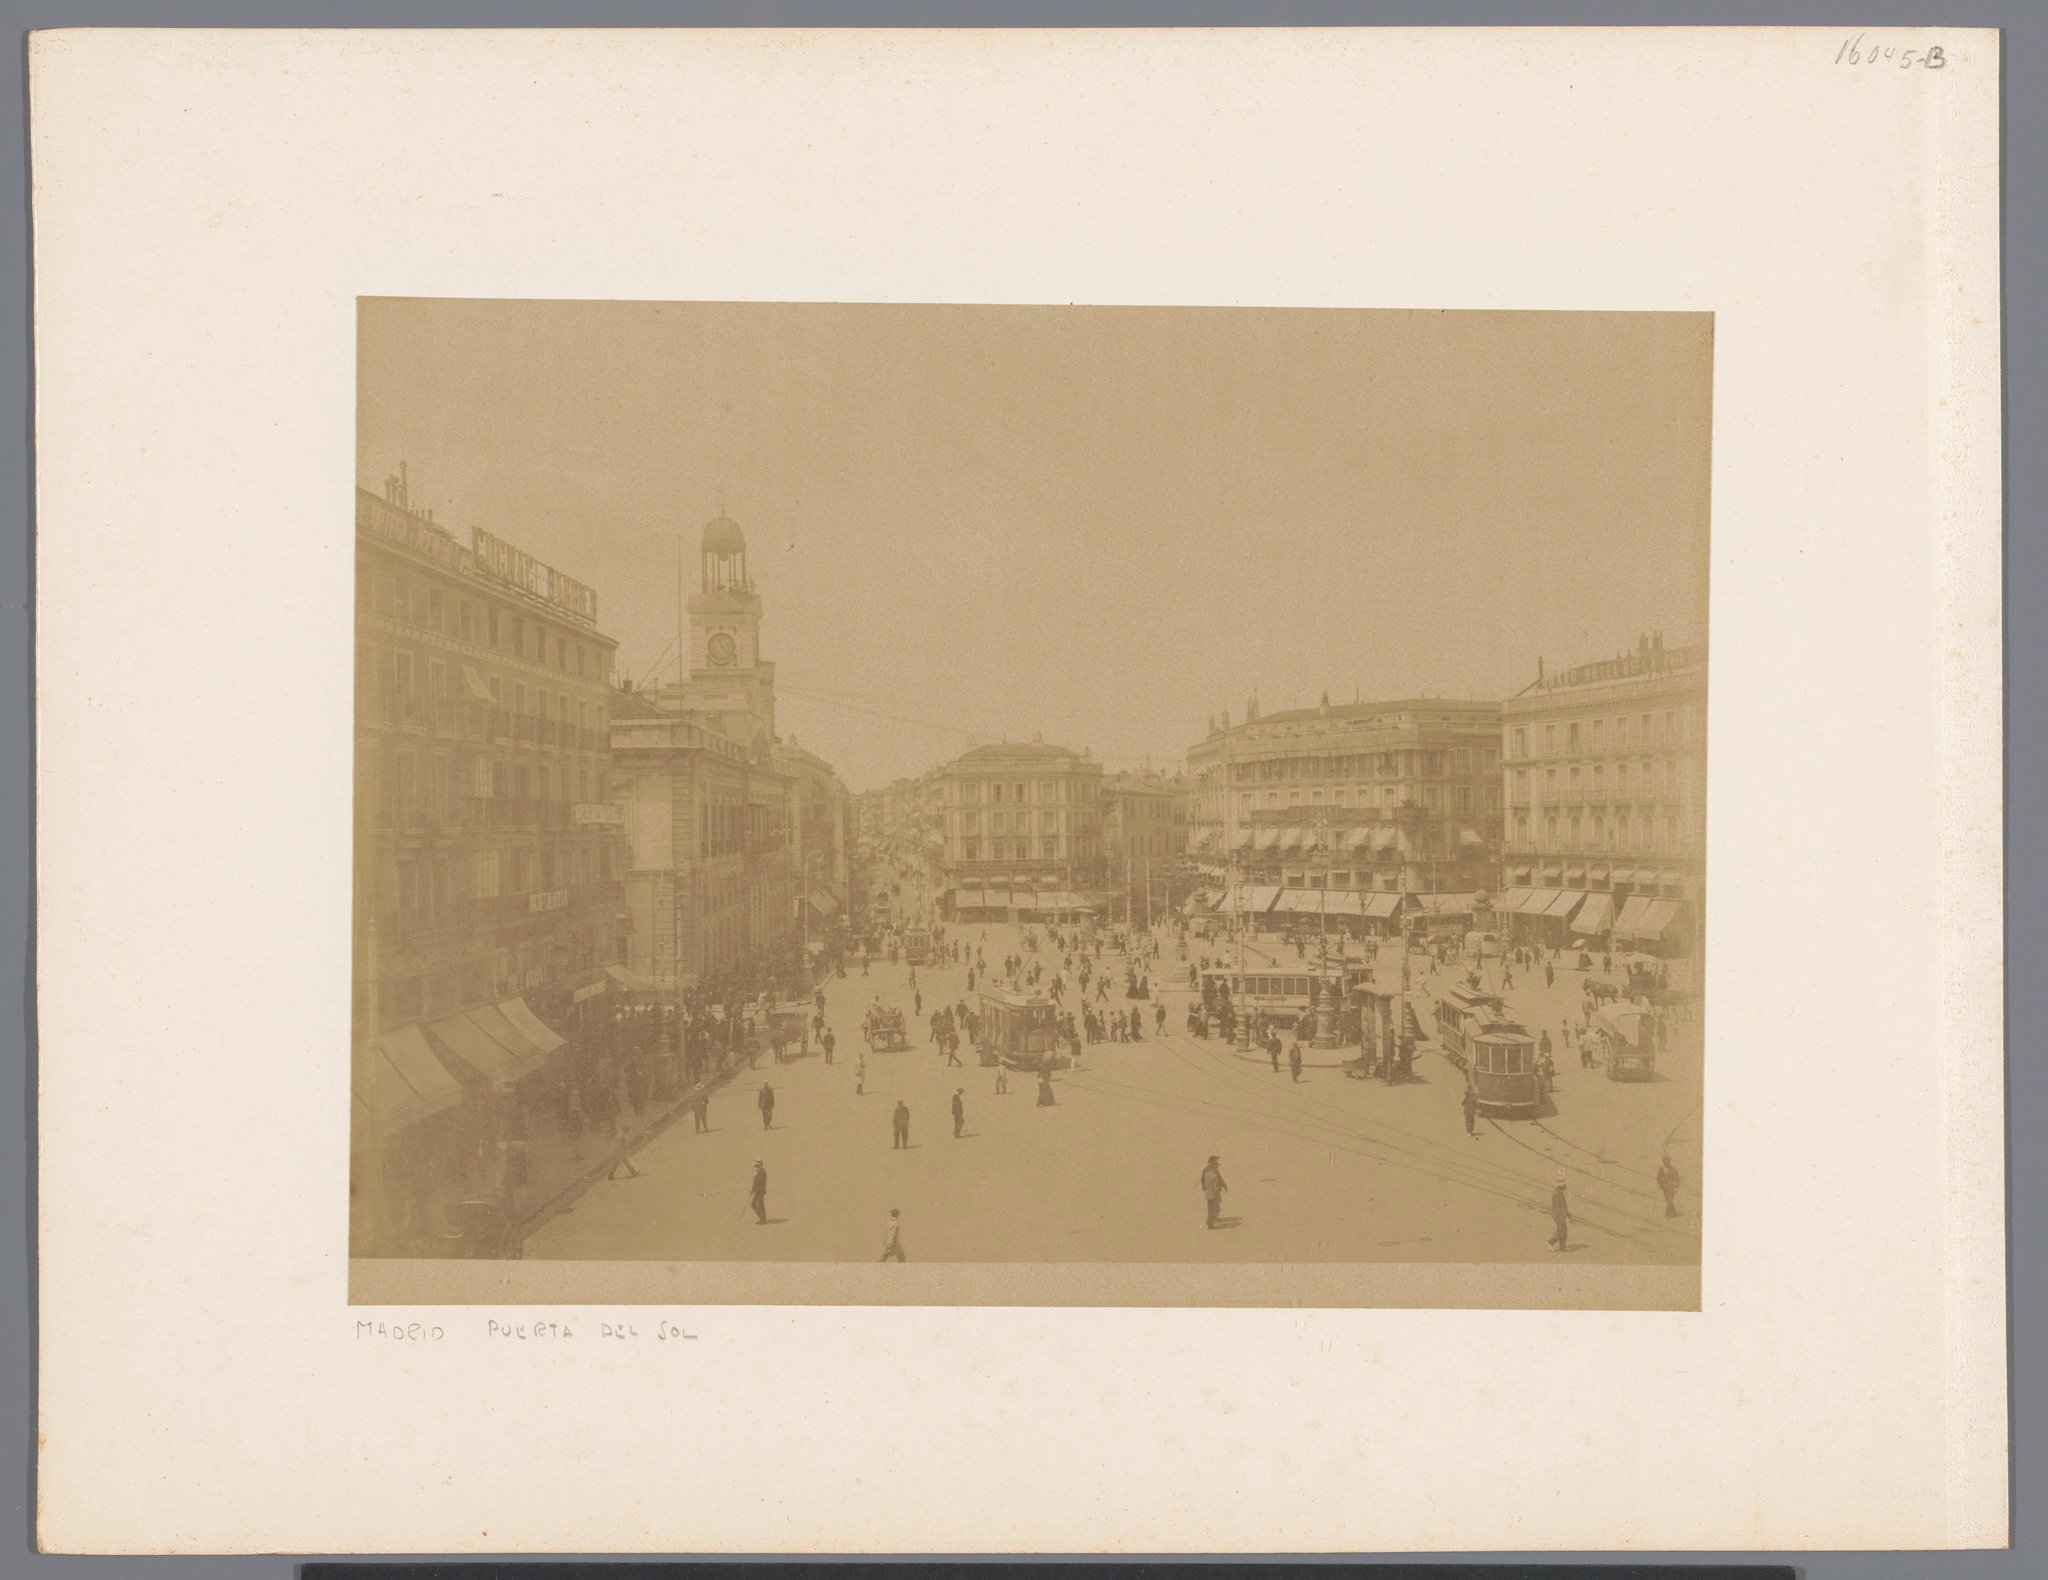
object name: photograph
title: Madrid, Puerta del Sol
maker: Anonymous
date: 1898-1910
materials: cardboard, paper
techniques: albumen print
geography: madrid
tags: square, place, circus, etc.